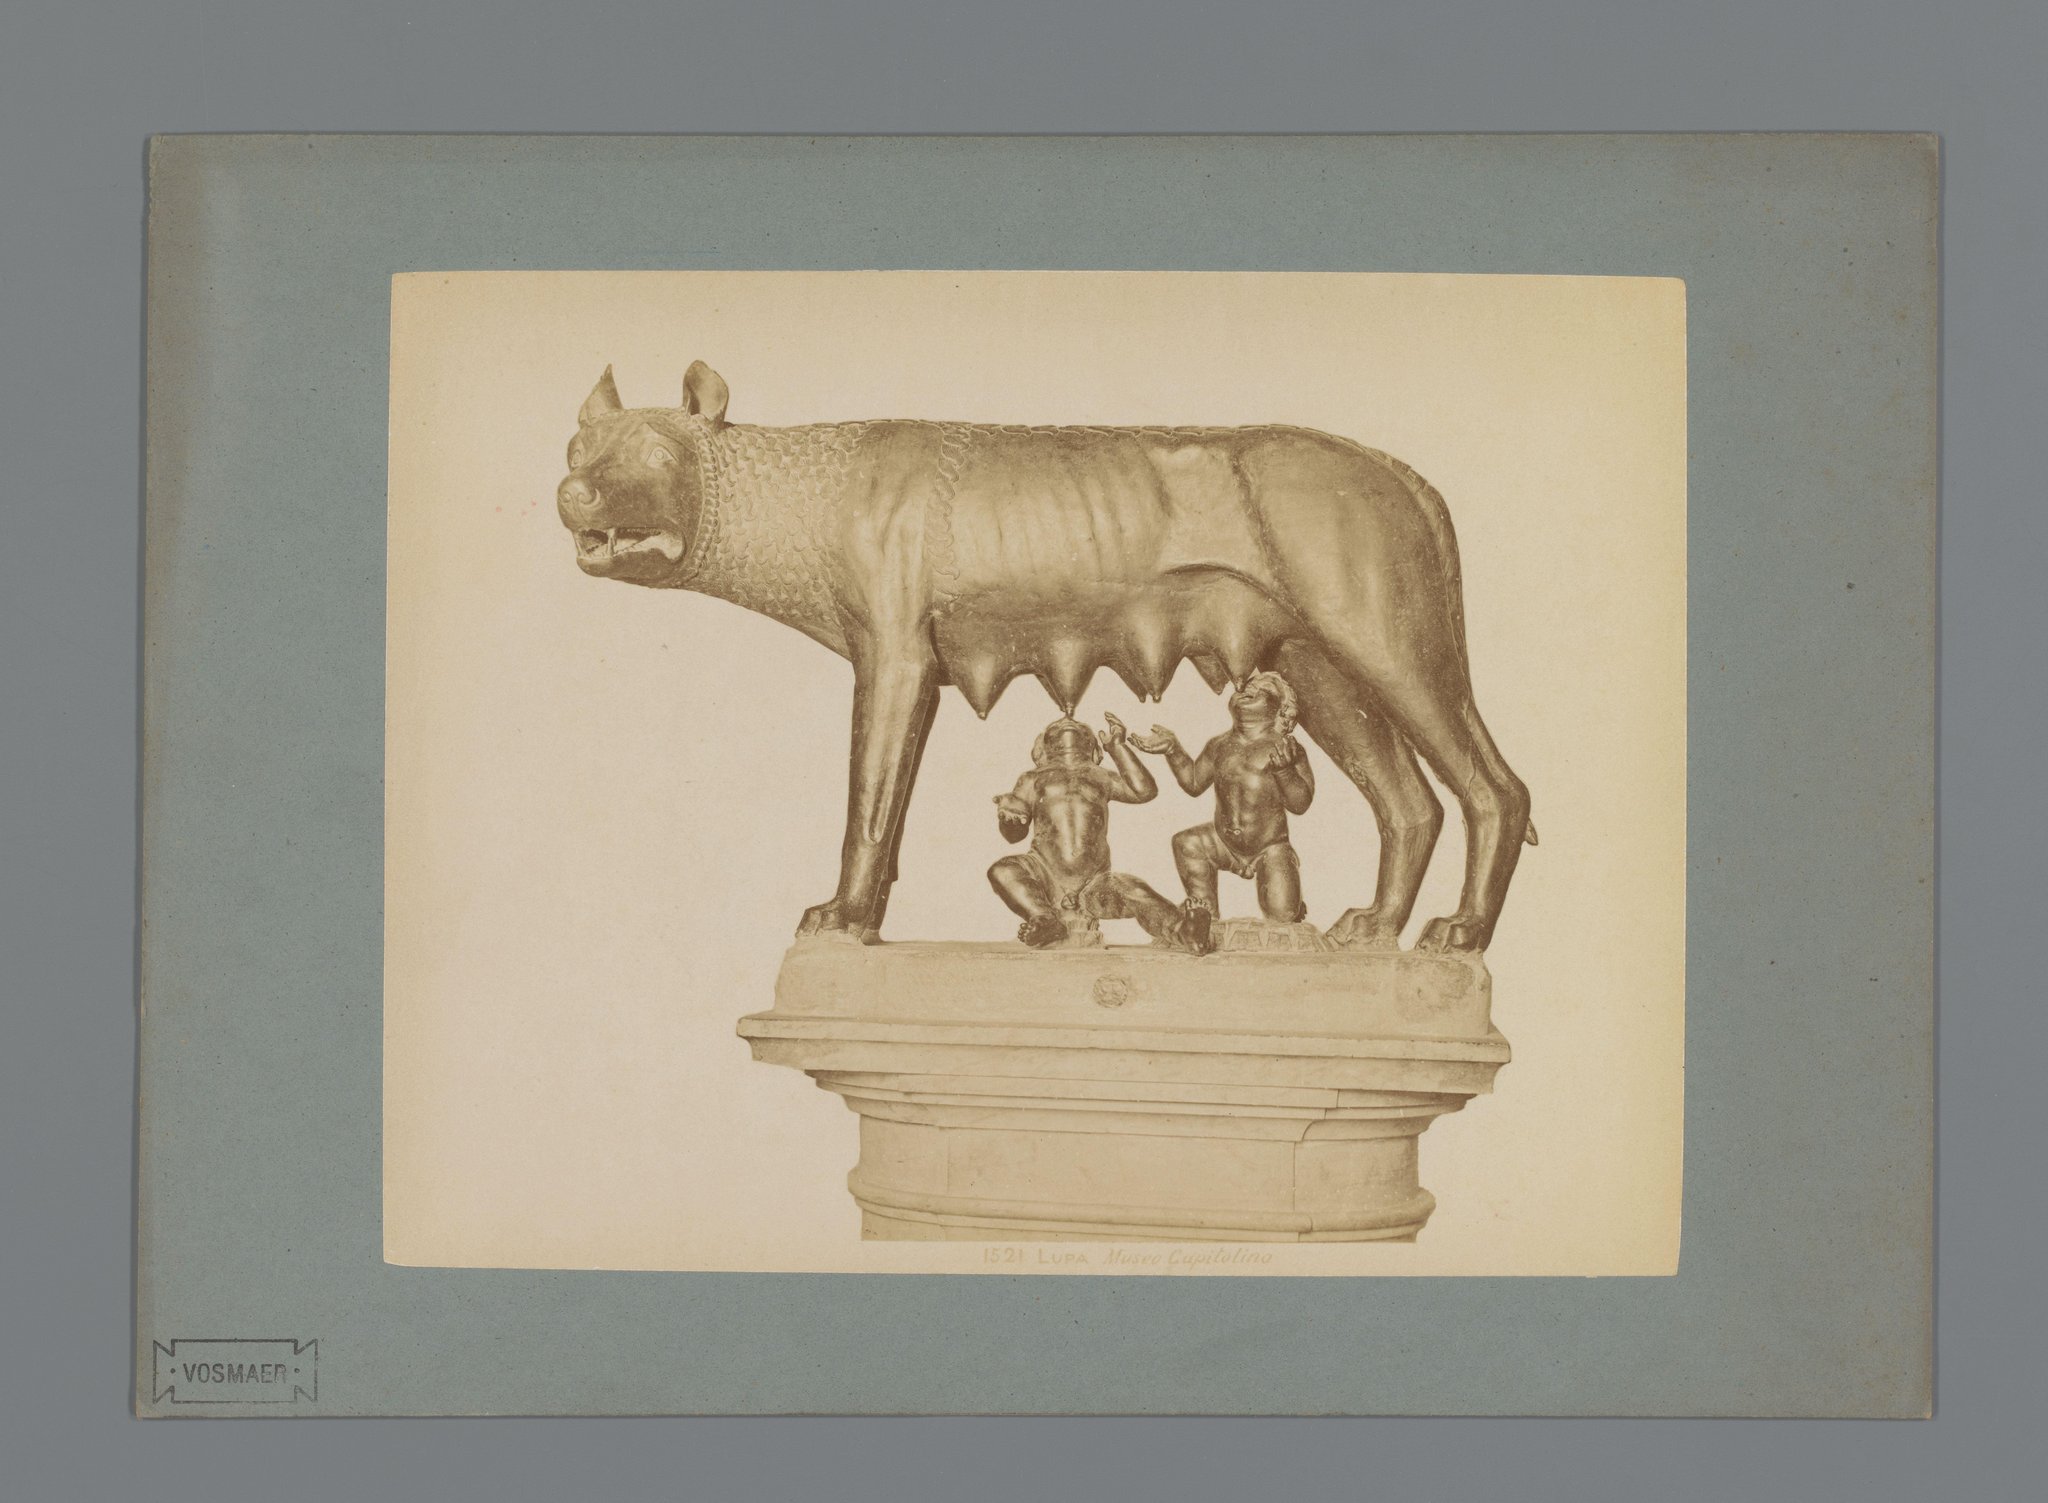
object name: photograph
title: Lupa. Museo Capitolina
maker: Anonymous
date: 1851-1890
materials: cardboard, paper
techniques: albumen print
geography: rome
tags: romulus and remus are washed ashore and suckled by a she-wolf; 'lupa romana'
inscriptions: collector's mark: ‘VOSMAER’, number: ‘1521’